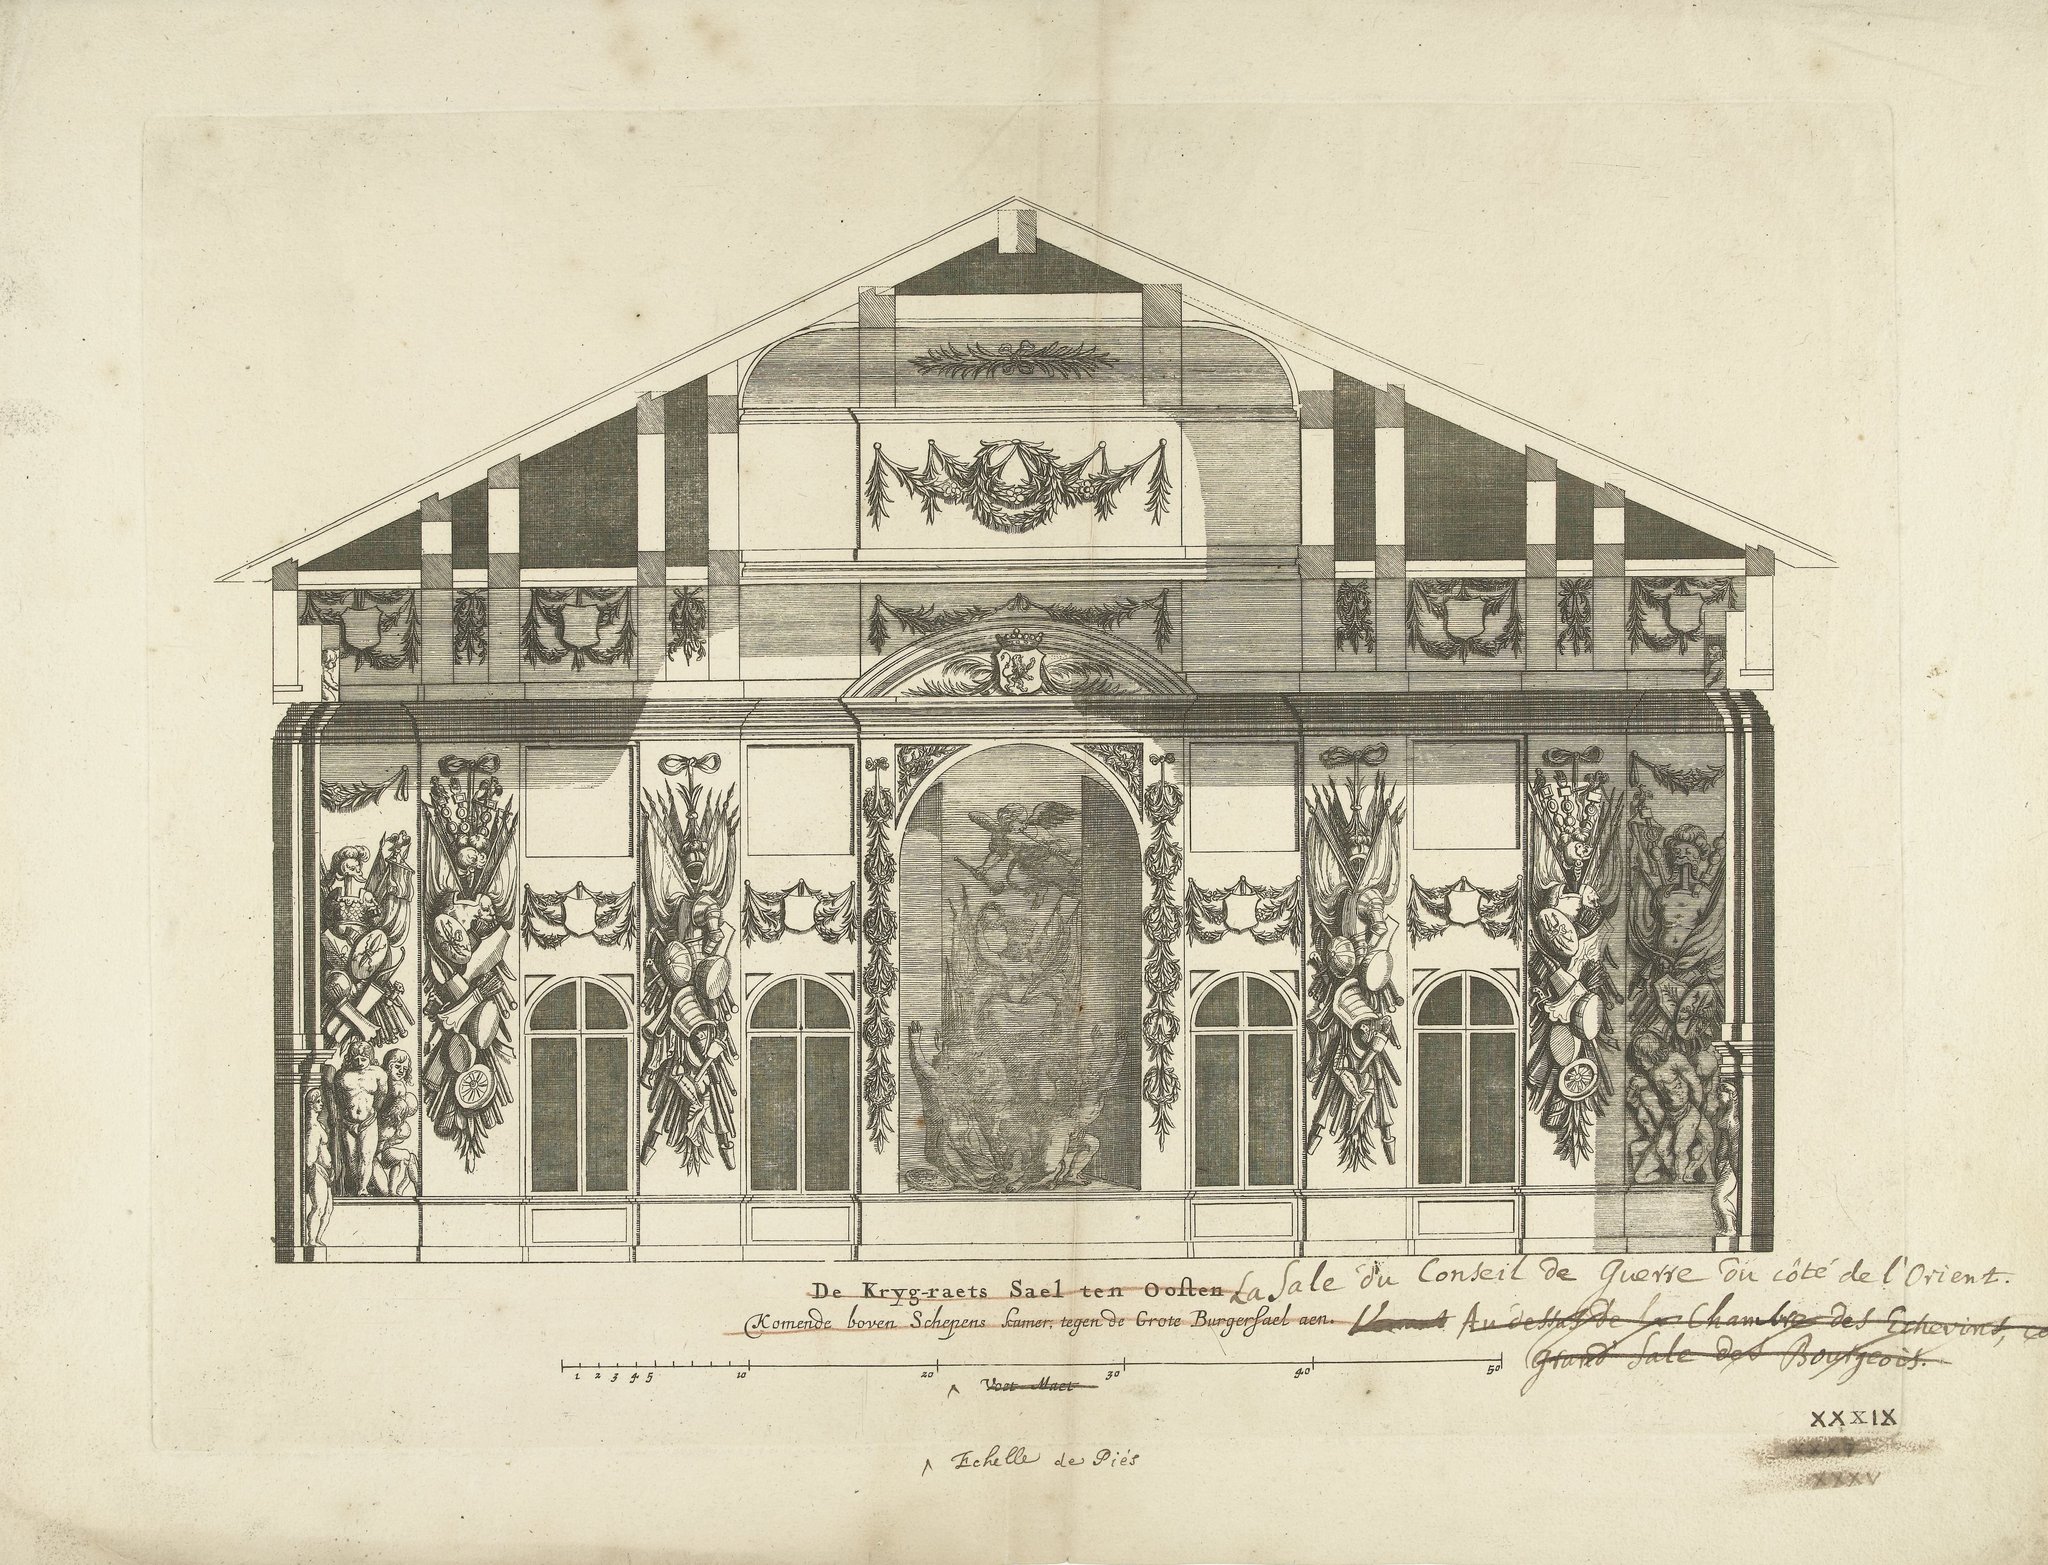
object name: book illustration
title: De Kryg-raets Sael ten Oosten. Komende boven Schepens kamer, tegen de Grote Burgersael aen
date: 1661-1706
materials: ink, paper, pencil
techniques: engraving, etching, pen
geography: amsterdam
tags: interior ~ architectural design or model, weapons, fama as roman personification, townhall, interior ~ representation of a building, council of war, coat of arms (as symbol of the state, etc.) (+ province; provincial)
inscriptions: inscription: ‘XX[X]IX’, collector's mark: Lugt 240, inscription: ‘La Sale du Conseil de Guerre du côté de l'Orient’, inscription: ‘Echelle de Pies’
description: De oostelijke wand van de Krijgsraadzaal in het Stadhuis op de Dam te Amsterdam, voorzien van decoraties. Deze zaal bevond zich boven de Schepenzaal. Onder de titel een schaalstok: 50 Voet Maet. Rechtsonder gemerkt: X [met handgeschreven cijfers erbij: XXXIX]. De titel is met de hand doorgehaald en vertaald in handgeschreven Franse tekst.